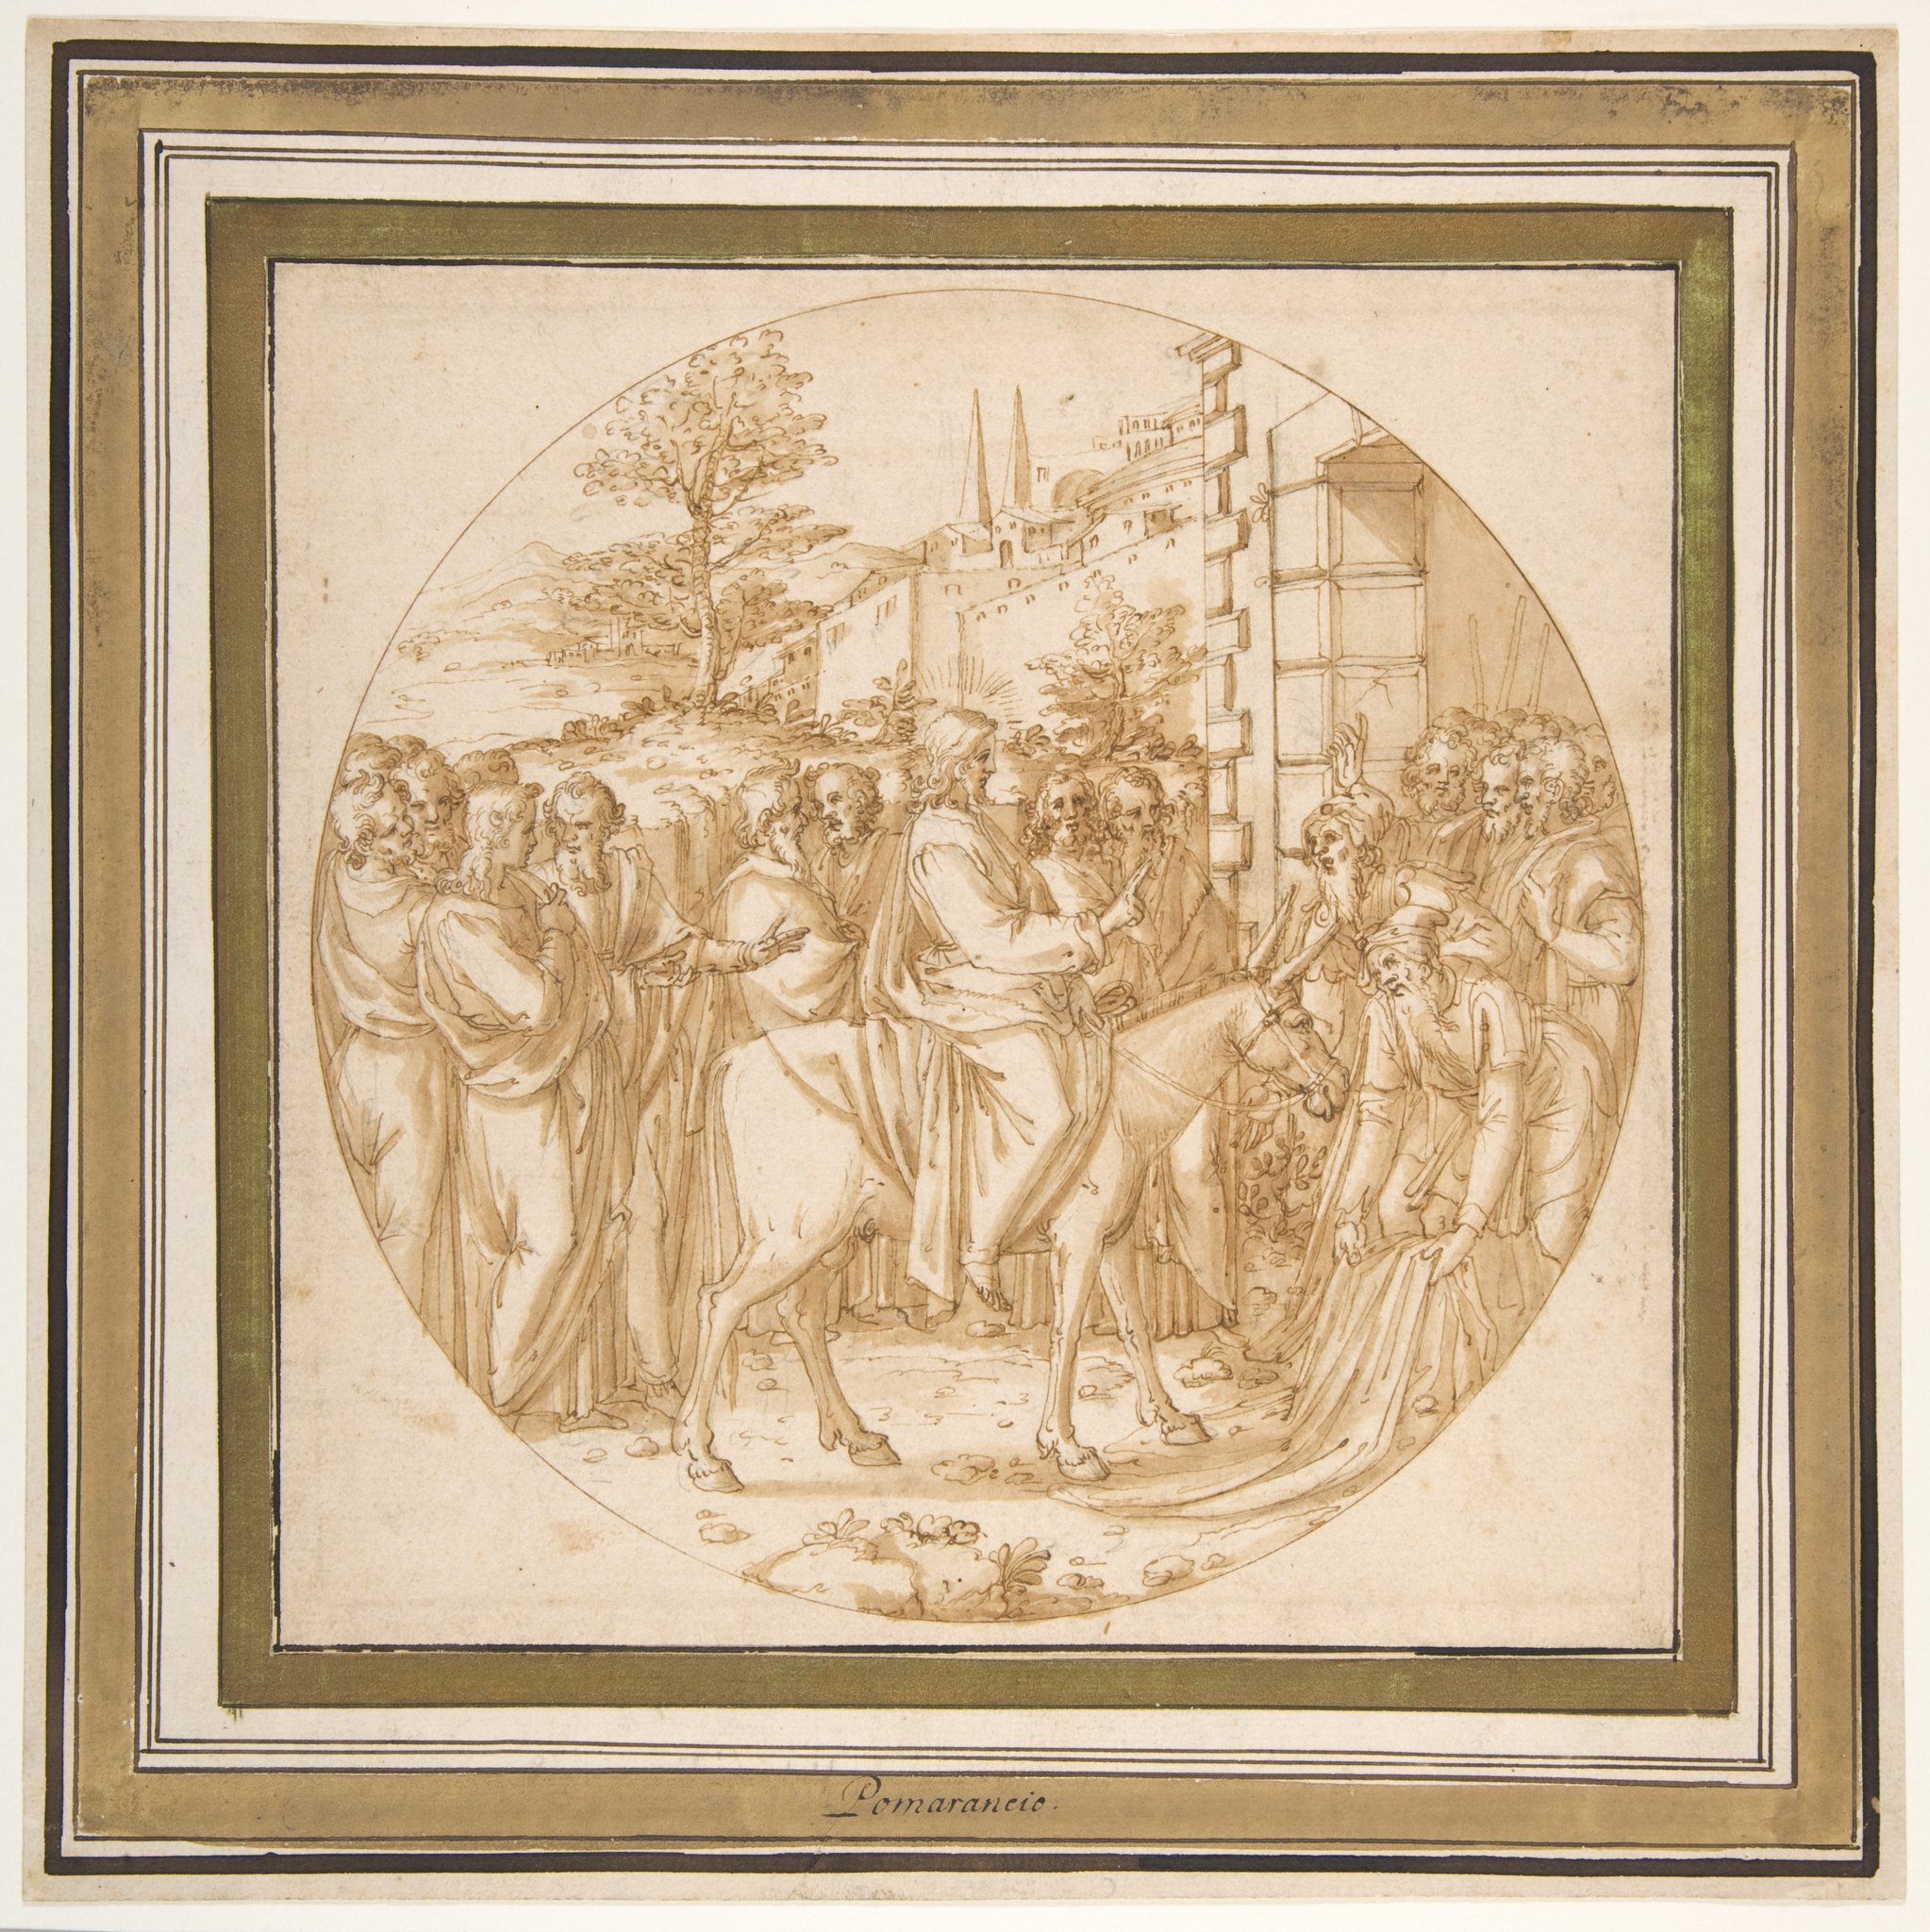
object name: drawing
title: The Entrance of Christ into Jerusalem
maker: ercole setti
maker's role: artist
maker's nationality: italian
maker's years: 1500-1600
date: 1501-1600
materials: chalk, ink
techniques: pen, wash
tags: palaces,men,women,horses,christ